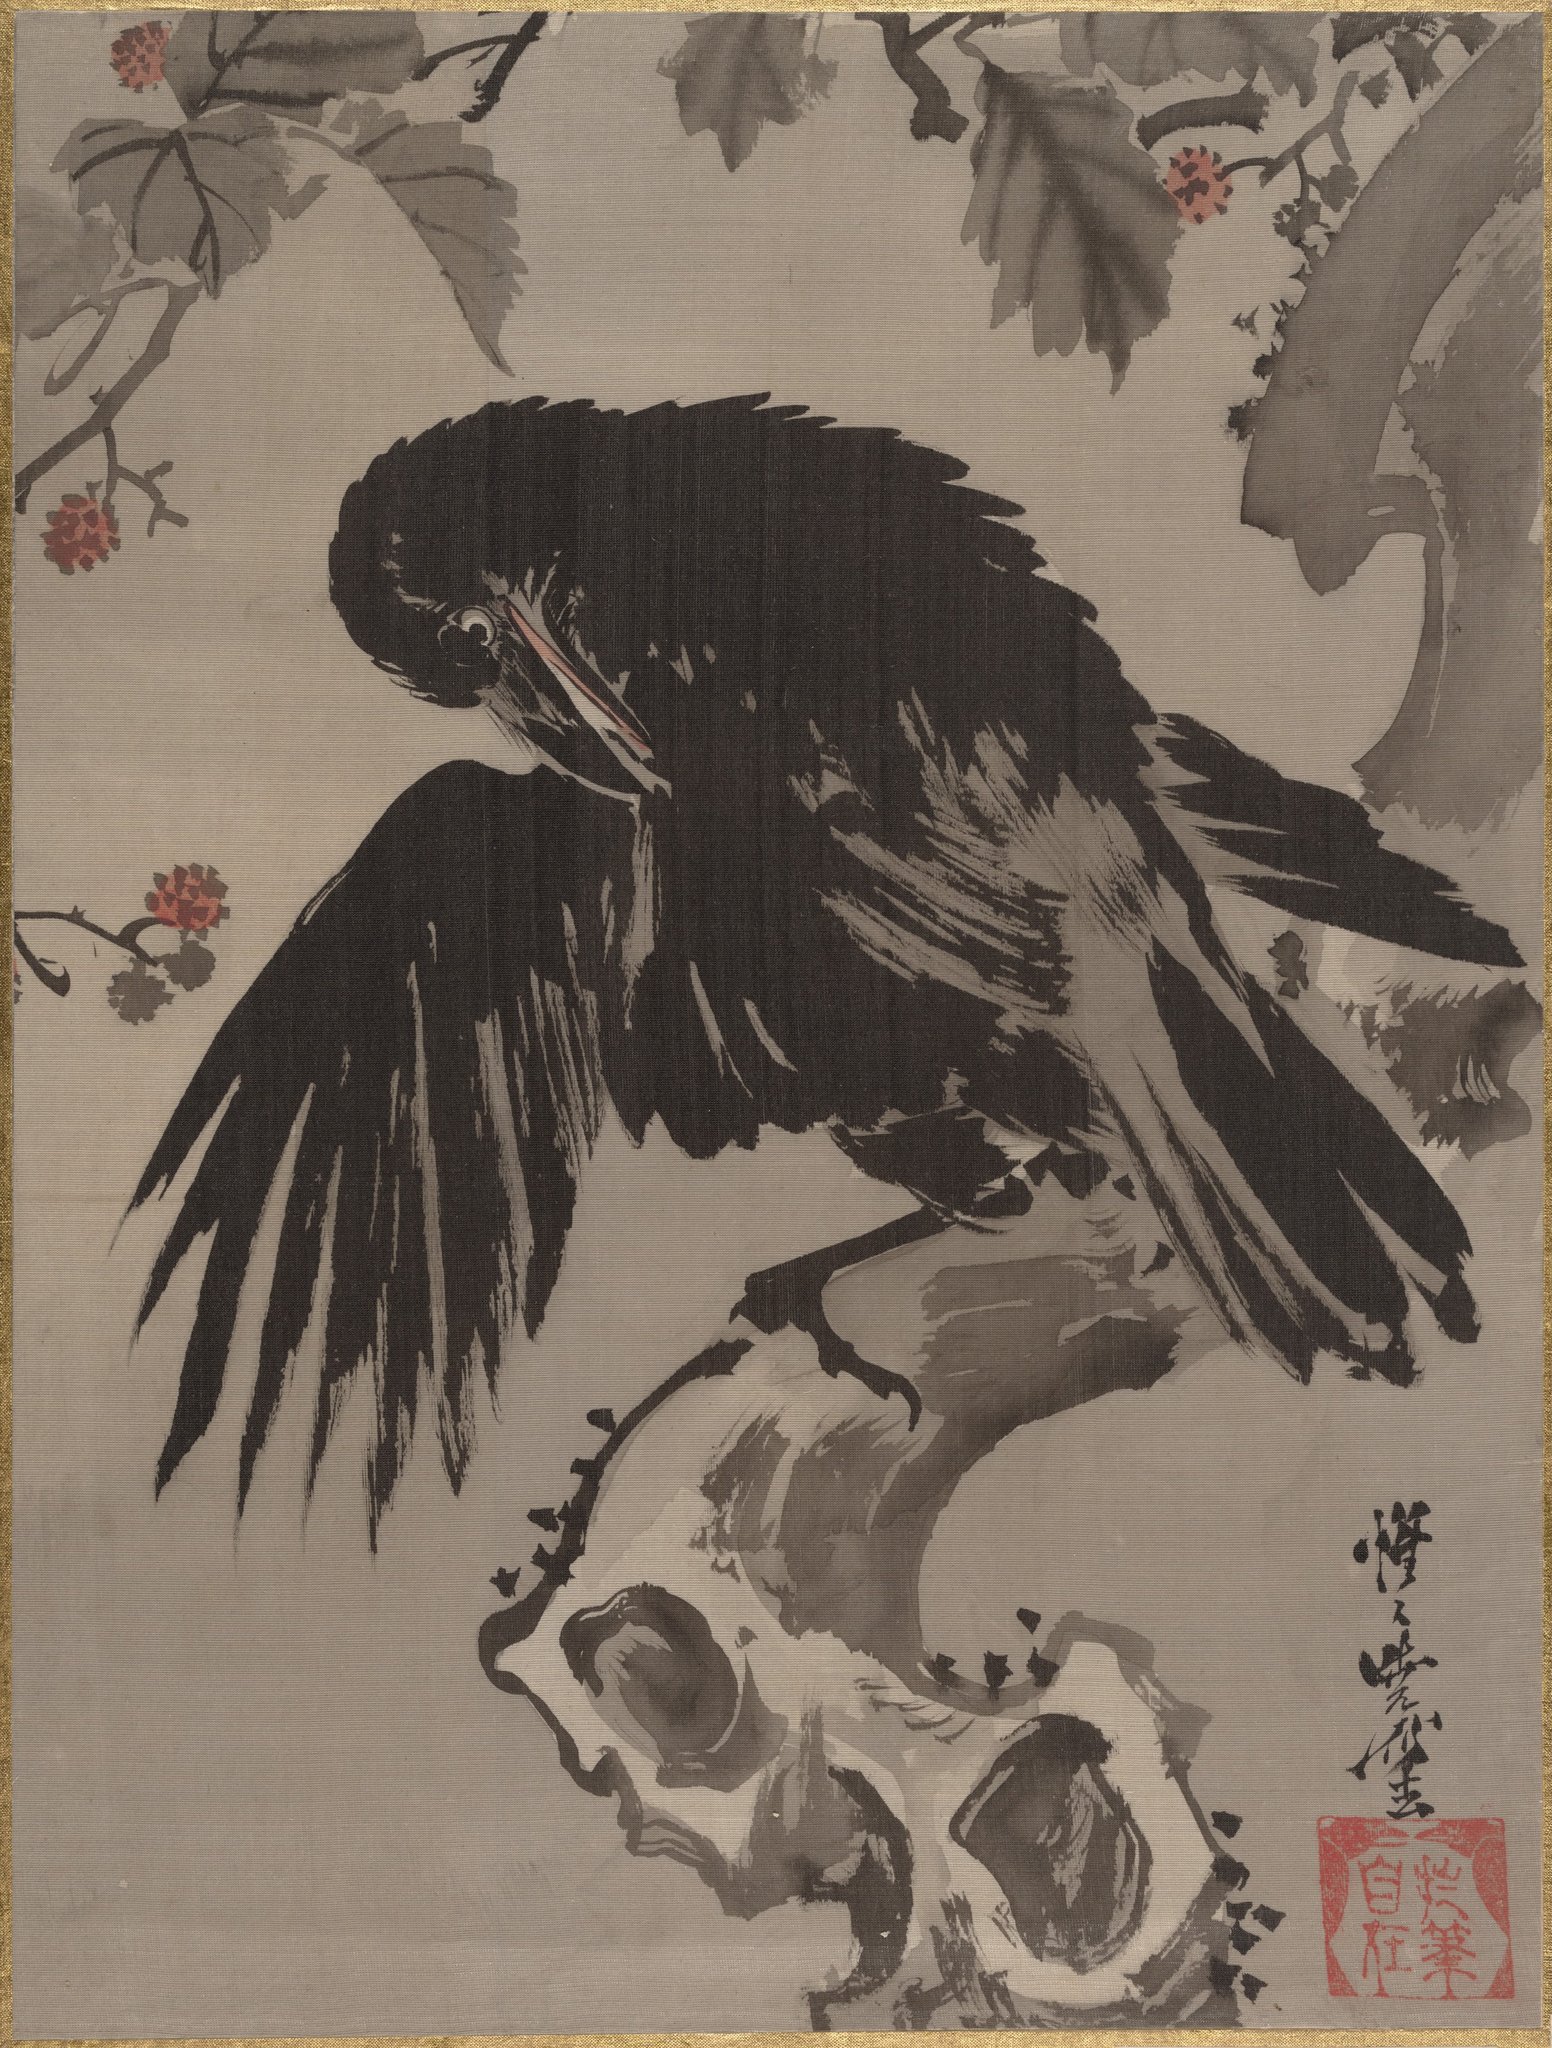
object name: album leaf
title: Crow on a Branch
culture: japanese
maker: kawanabe kyōsai 河鍋暁斎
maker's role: artist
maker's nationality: japanese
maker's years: 1831-1889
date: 1887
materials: ink, silk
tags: birds